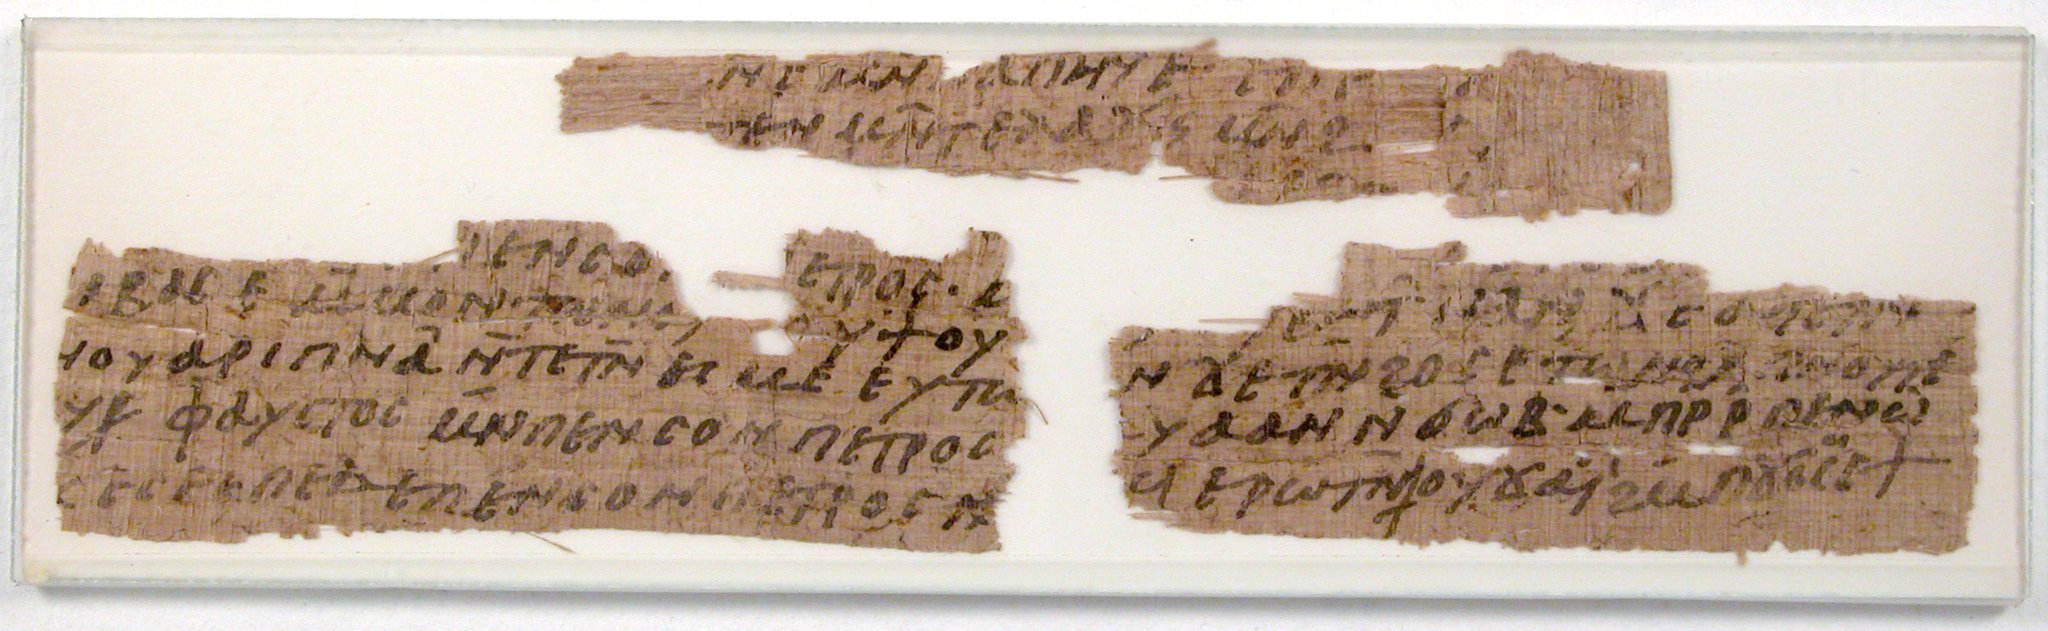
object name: fragment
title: Papyri Fragments of a Letter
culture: coptic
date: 601-700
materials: ink, papyrus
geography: egypt